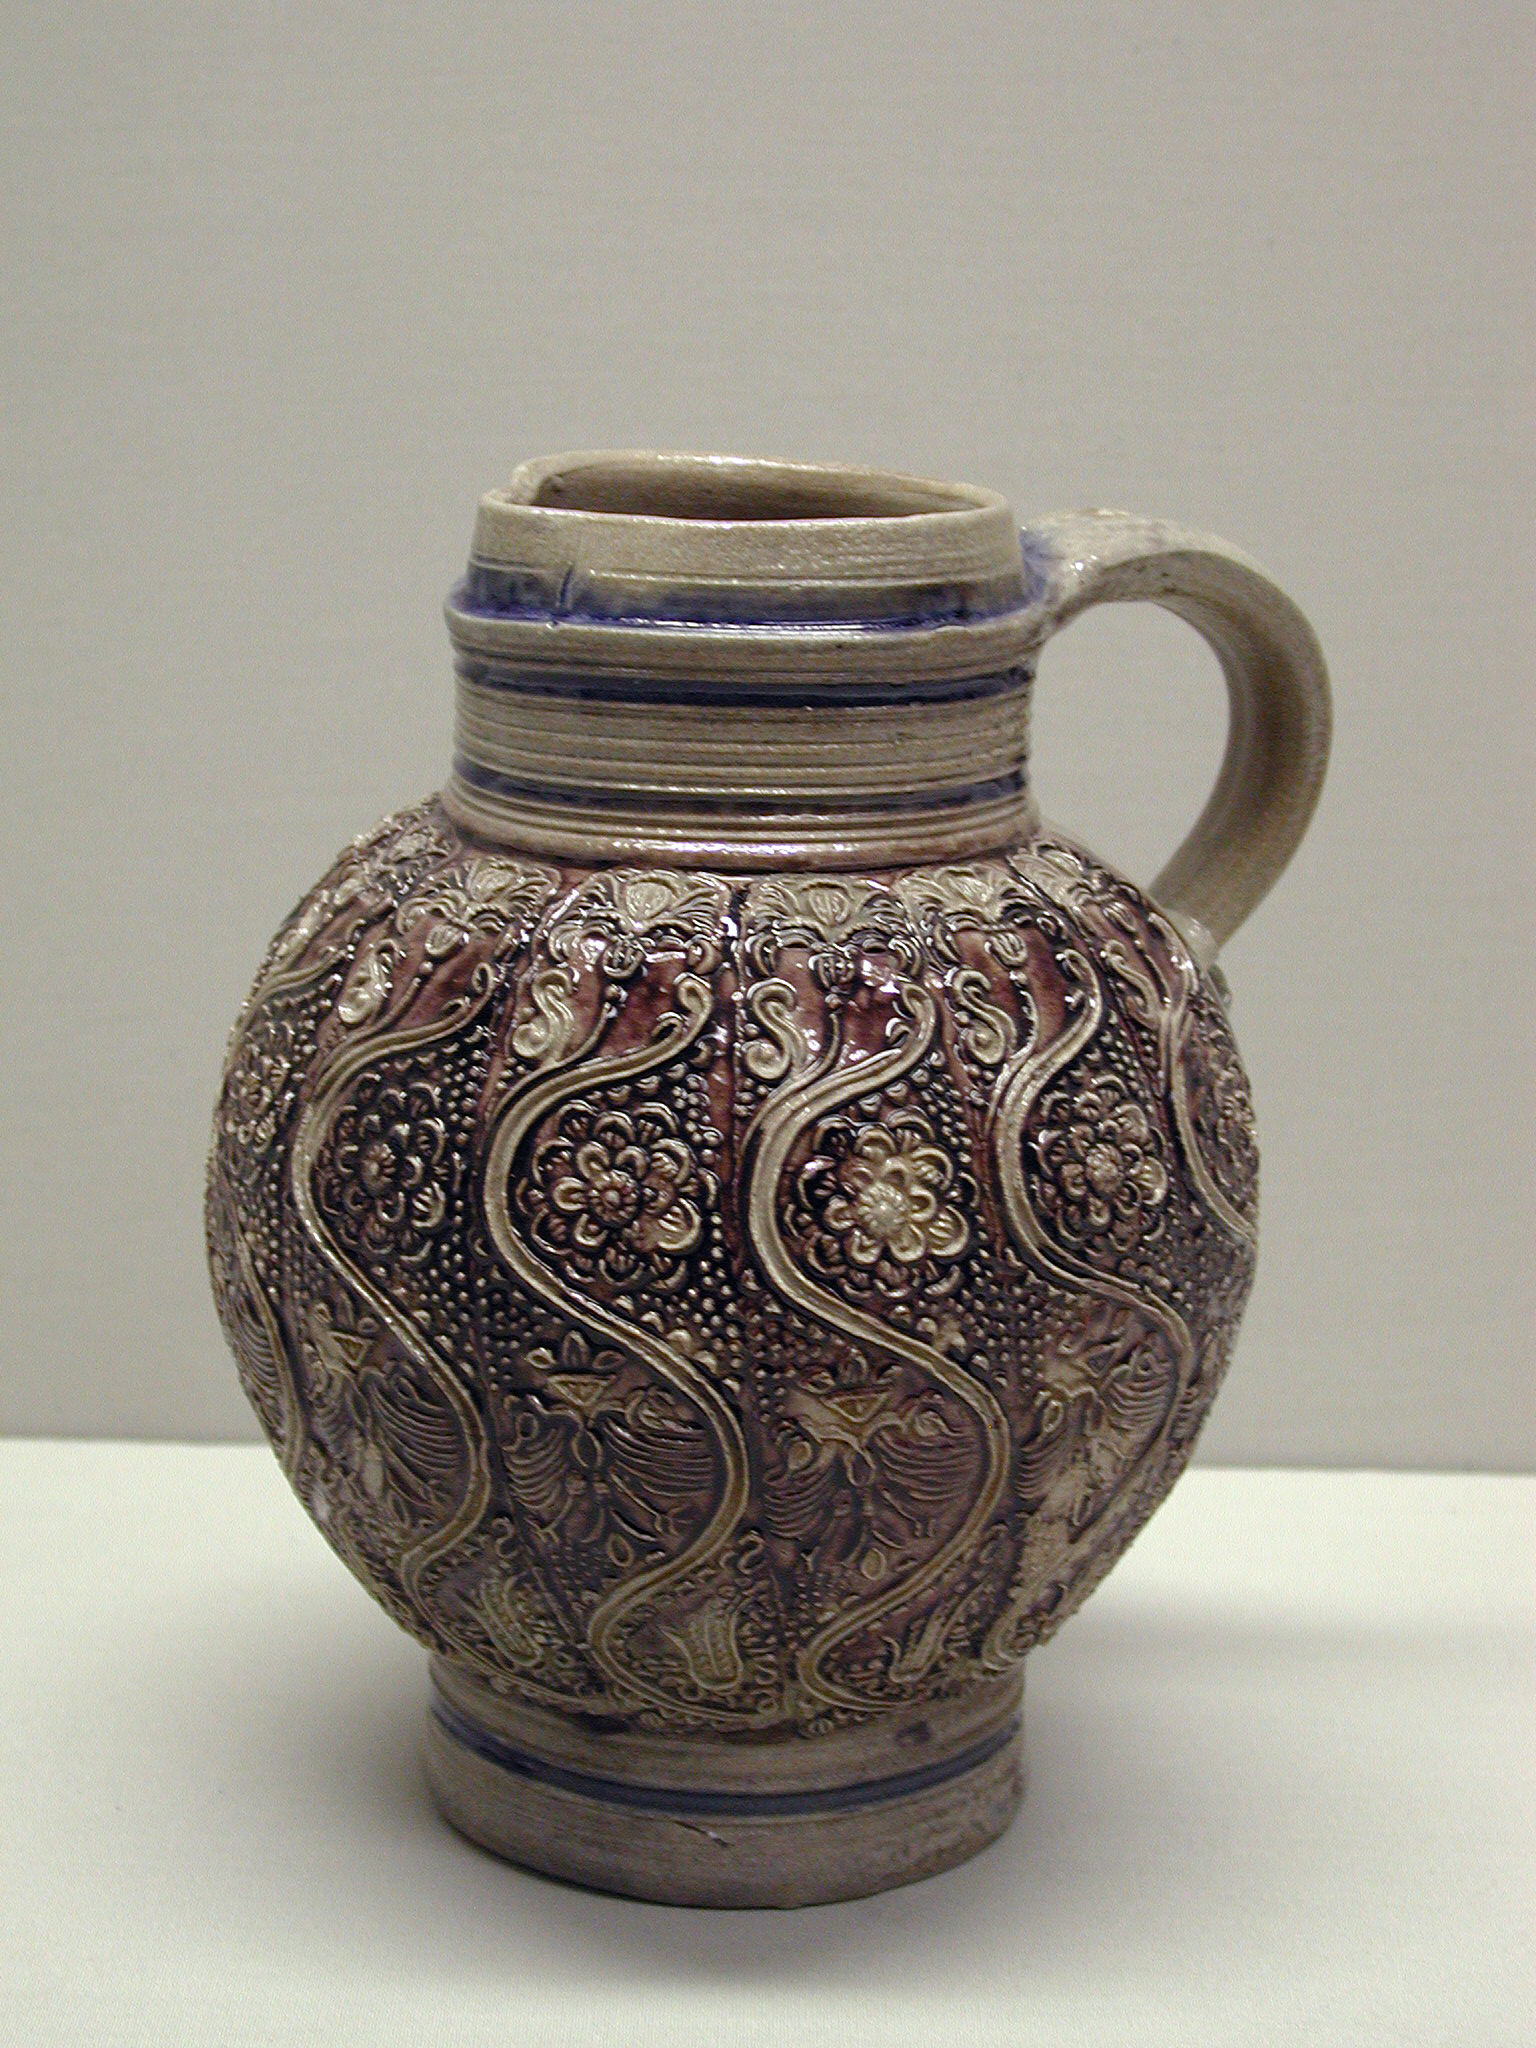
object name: jug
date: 1601-1700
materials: stoneware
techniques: salt glaze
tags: flowers